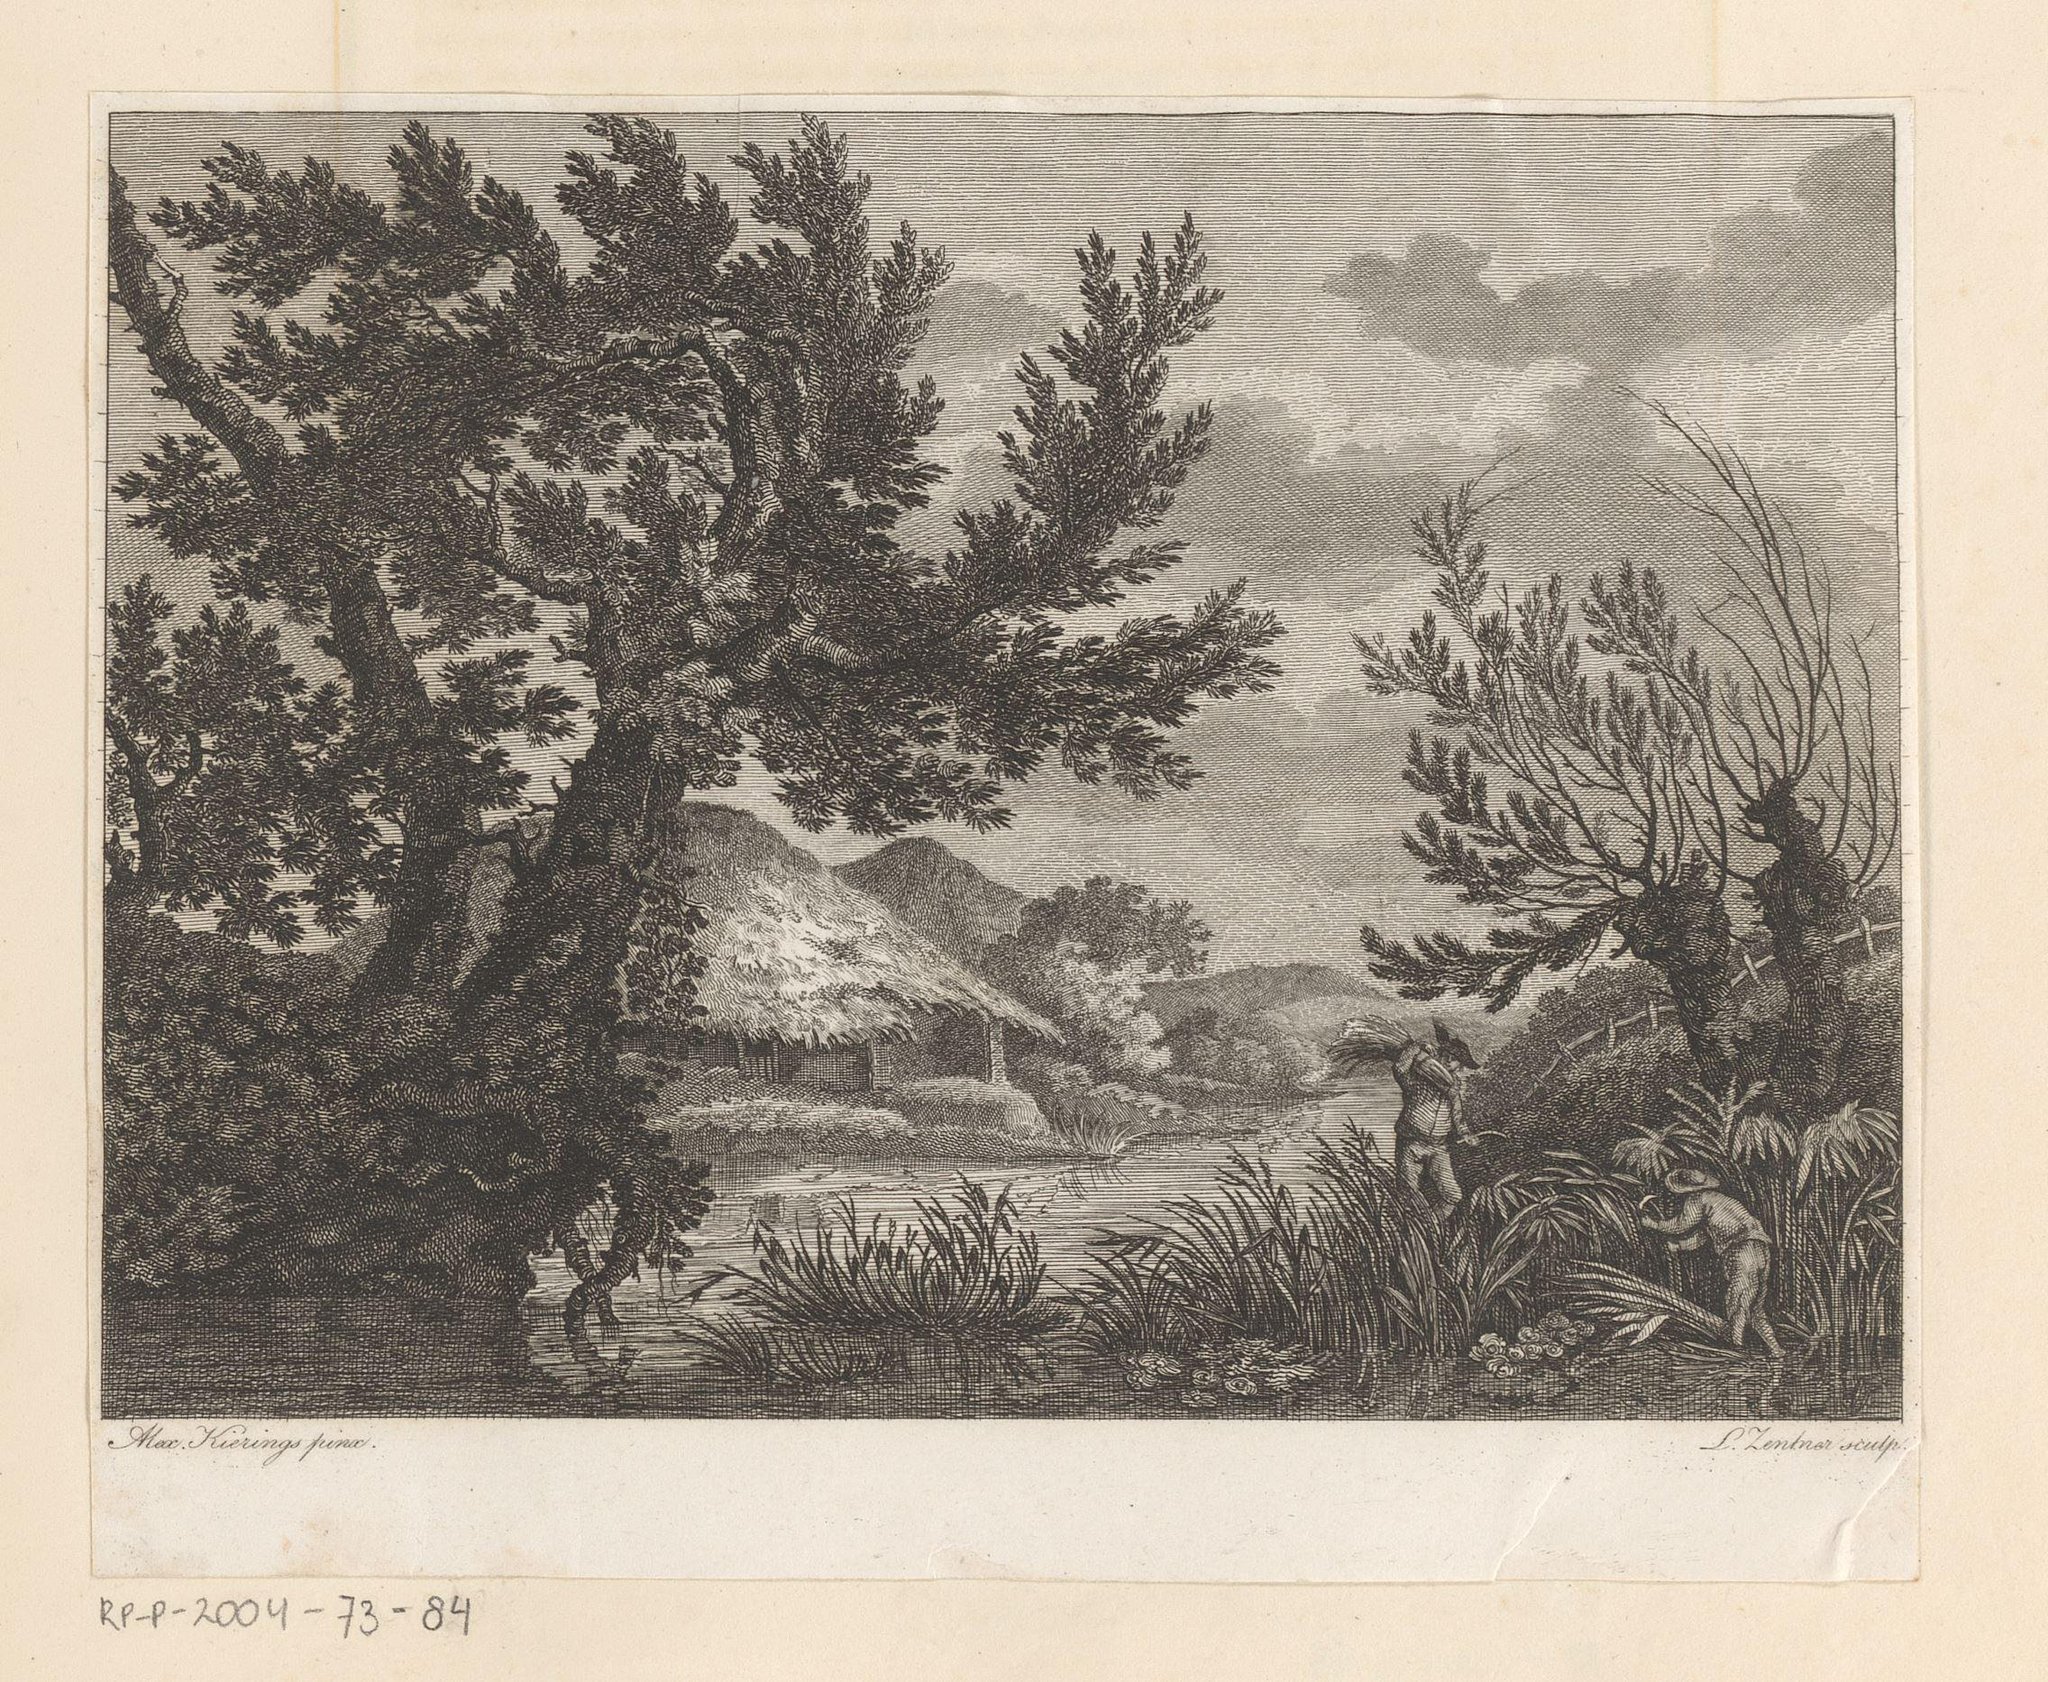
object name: print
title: Landschap met mannen die riet verzamelen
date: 1791-1798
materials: paper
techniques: engraving, etching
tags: river bank (+ landscape with figures, staffage)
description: Prent uit: Zentner, J.L.L.C.. A select Collection of landscapes, from the best old masters, one of each engraved by L. Zentner, after drawings made by him from original pictures (...). Londen: J. Thane, [1791-1798]. De samensteller heeft deze prent in het album geplakt als illustratie bij: Pilkington, Matthew en Johann Heinrich Füssli. A dictionary of painters, from the revival of the art to the present period. 4 dln. Londen: John Crowder, 1805, dl. 2, p. 270.